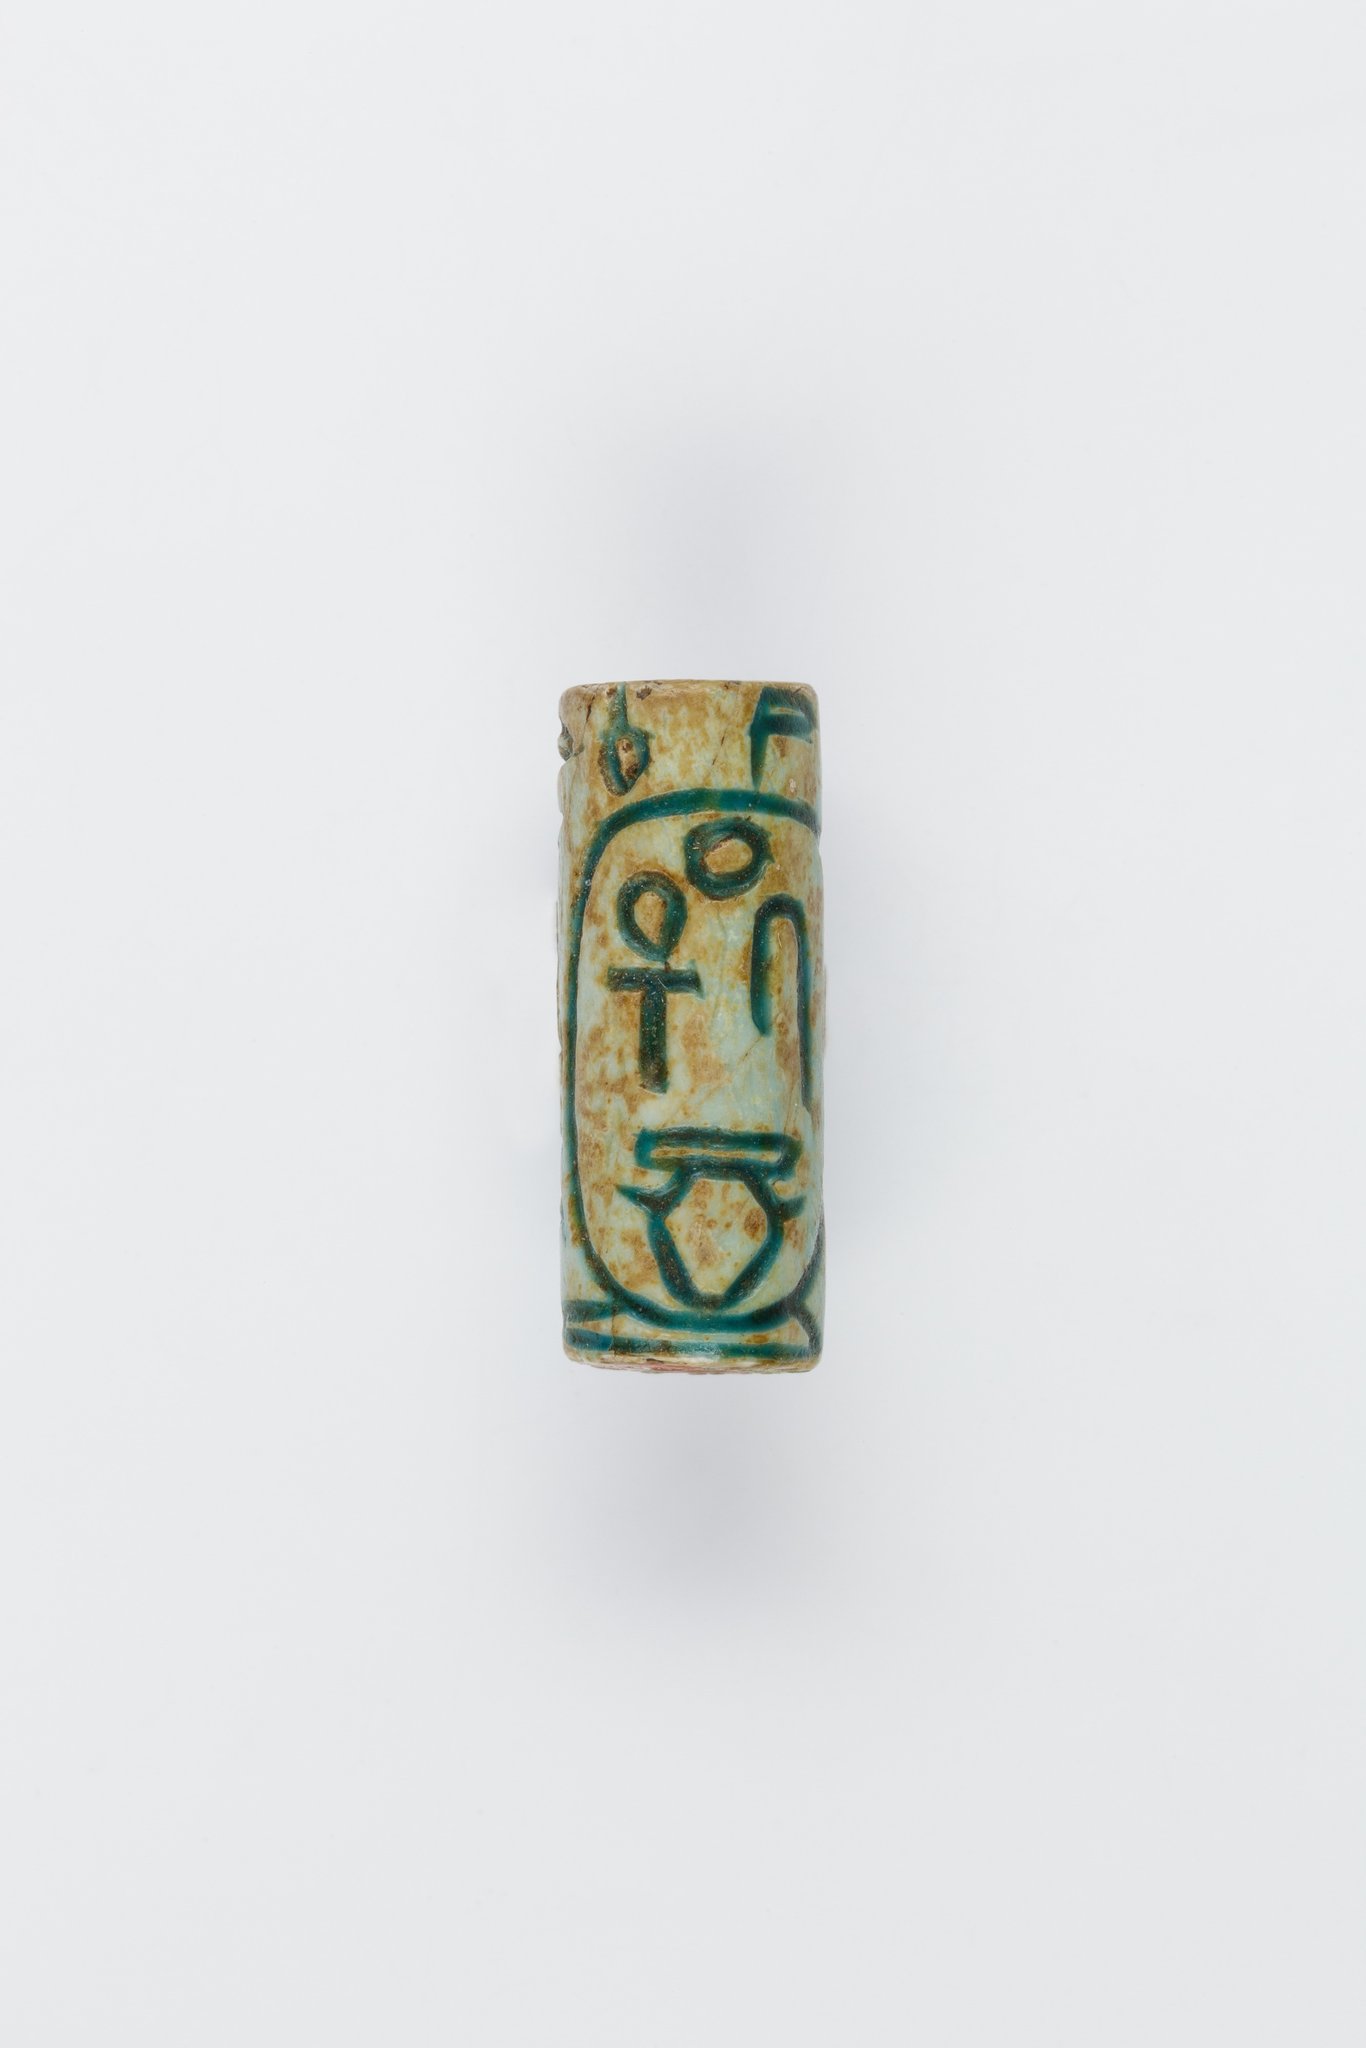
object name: cylinder seal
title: Cylinder Seal of King Seankhibre Amenemhat VI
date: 1787-1784 BCE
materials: stone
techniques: glazing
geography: egypt